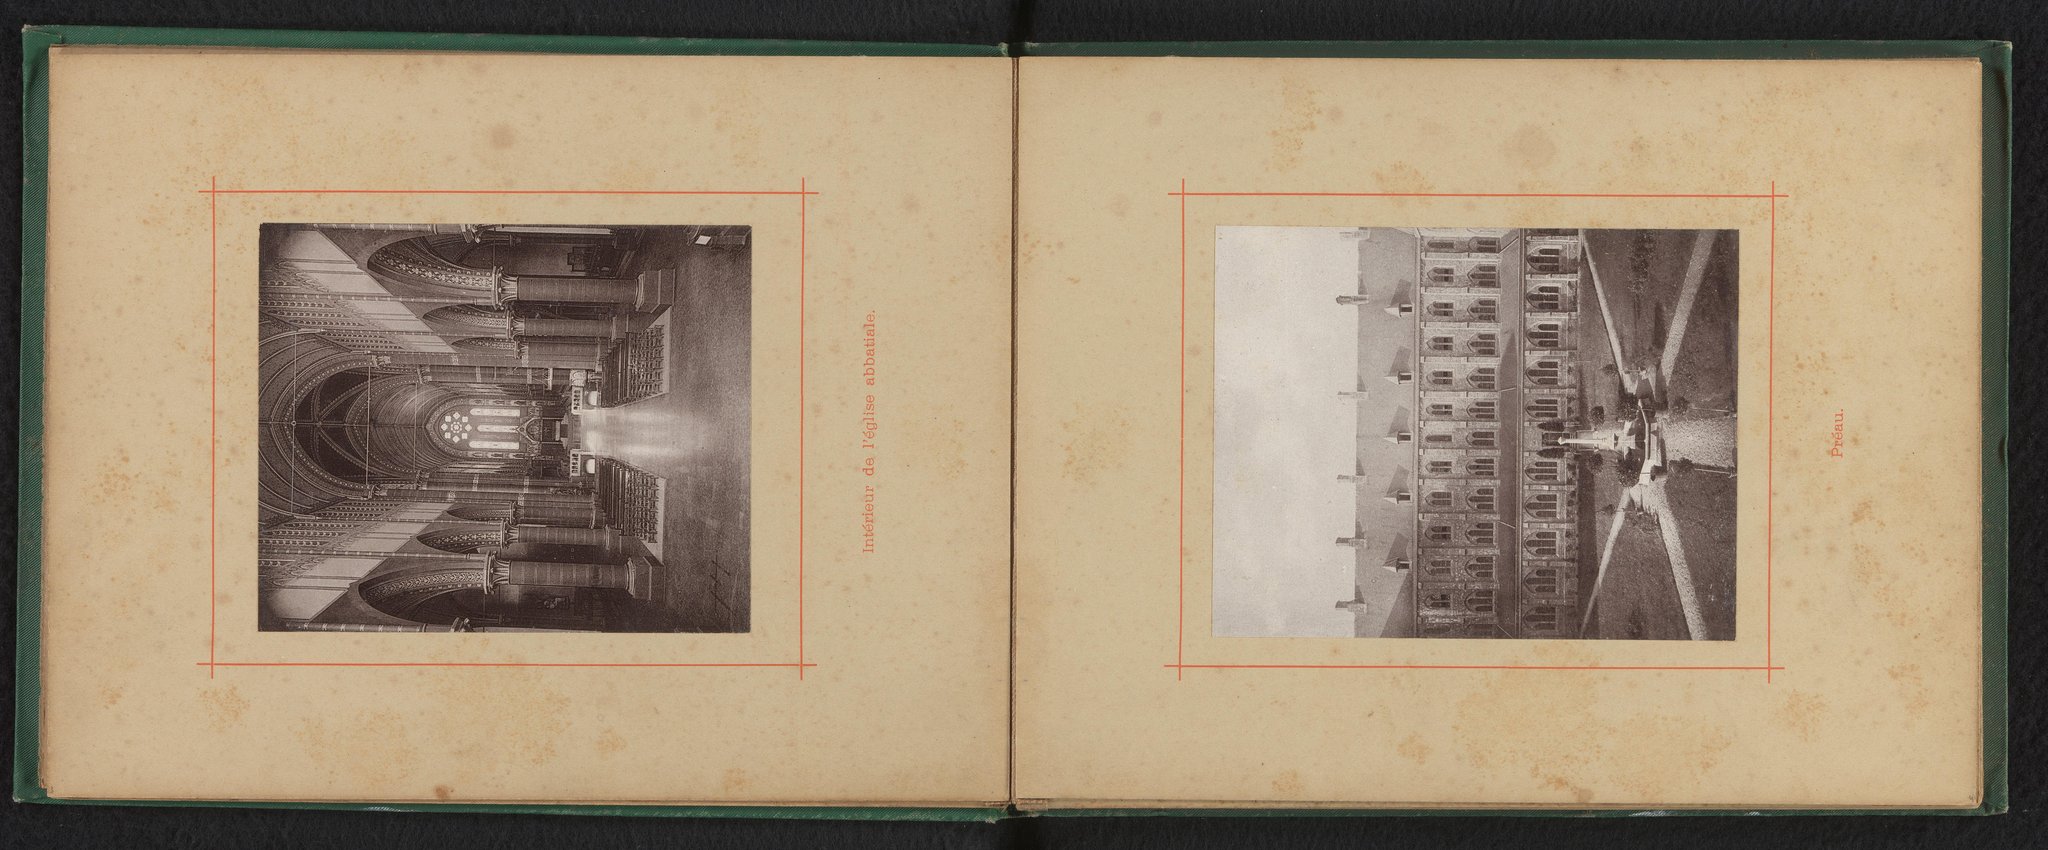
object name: photomechanical print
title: Préau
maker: Anonymous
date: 1900-1905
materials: paper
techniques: photograph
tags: abbey, monastery, convent ~ roman catholic church, courtyard